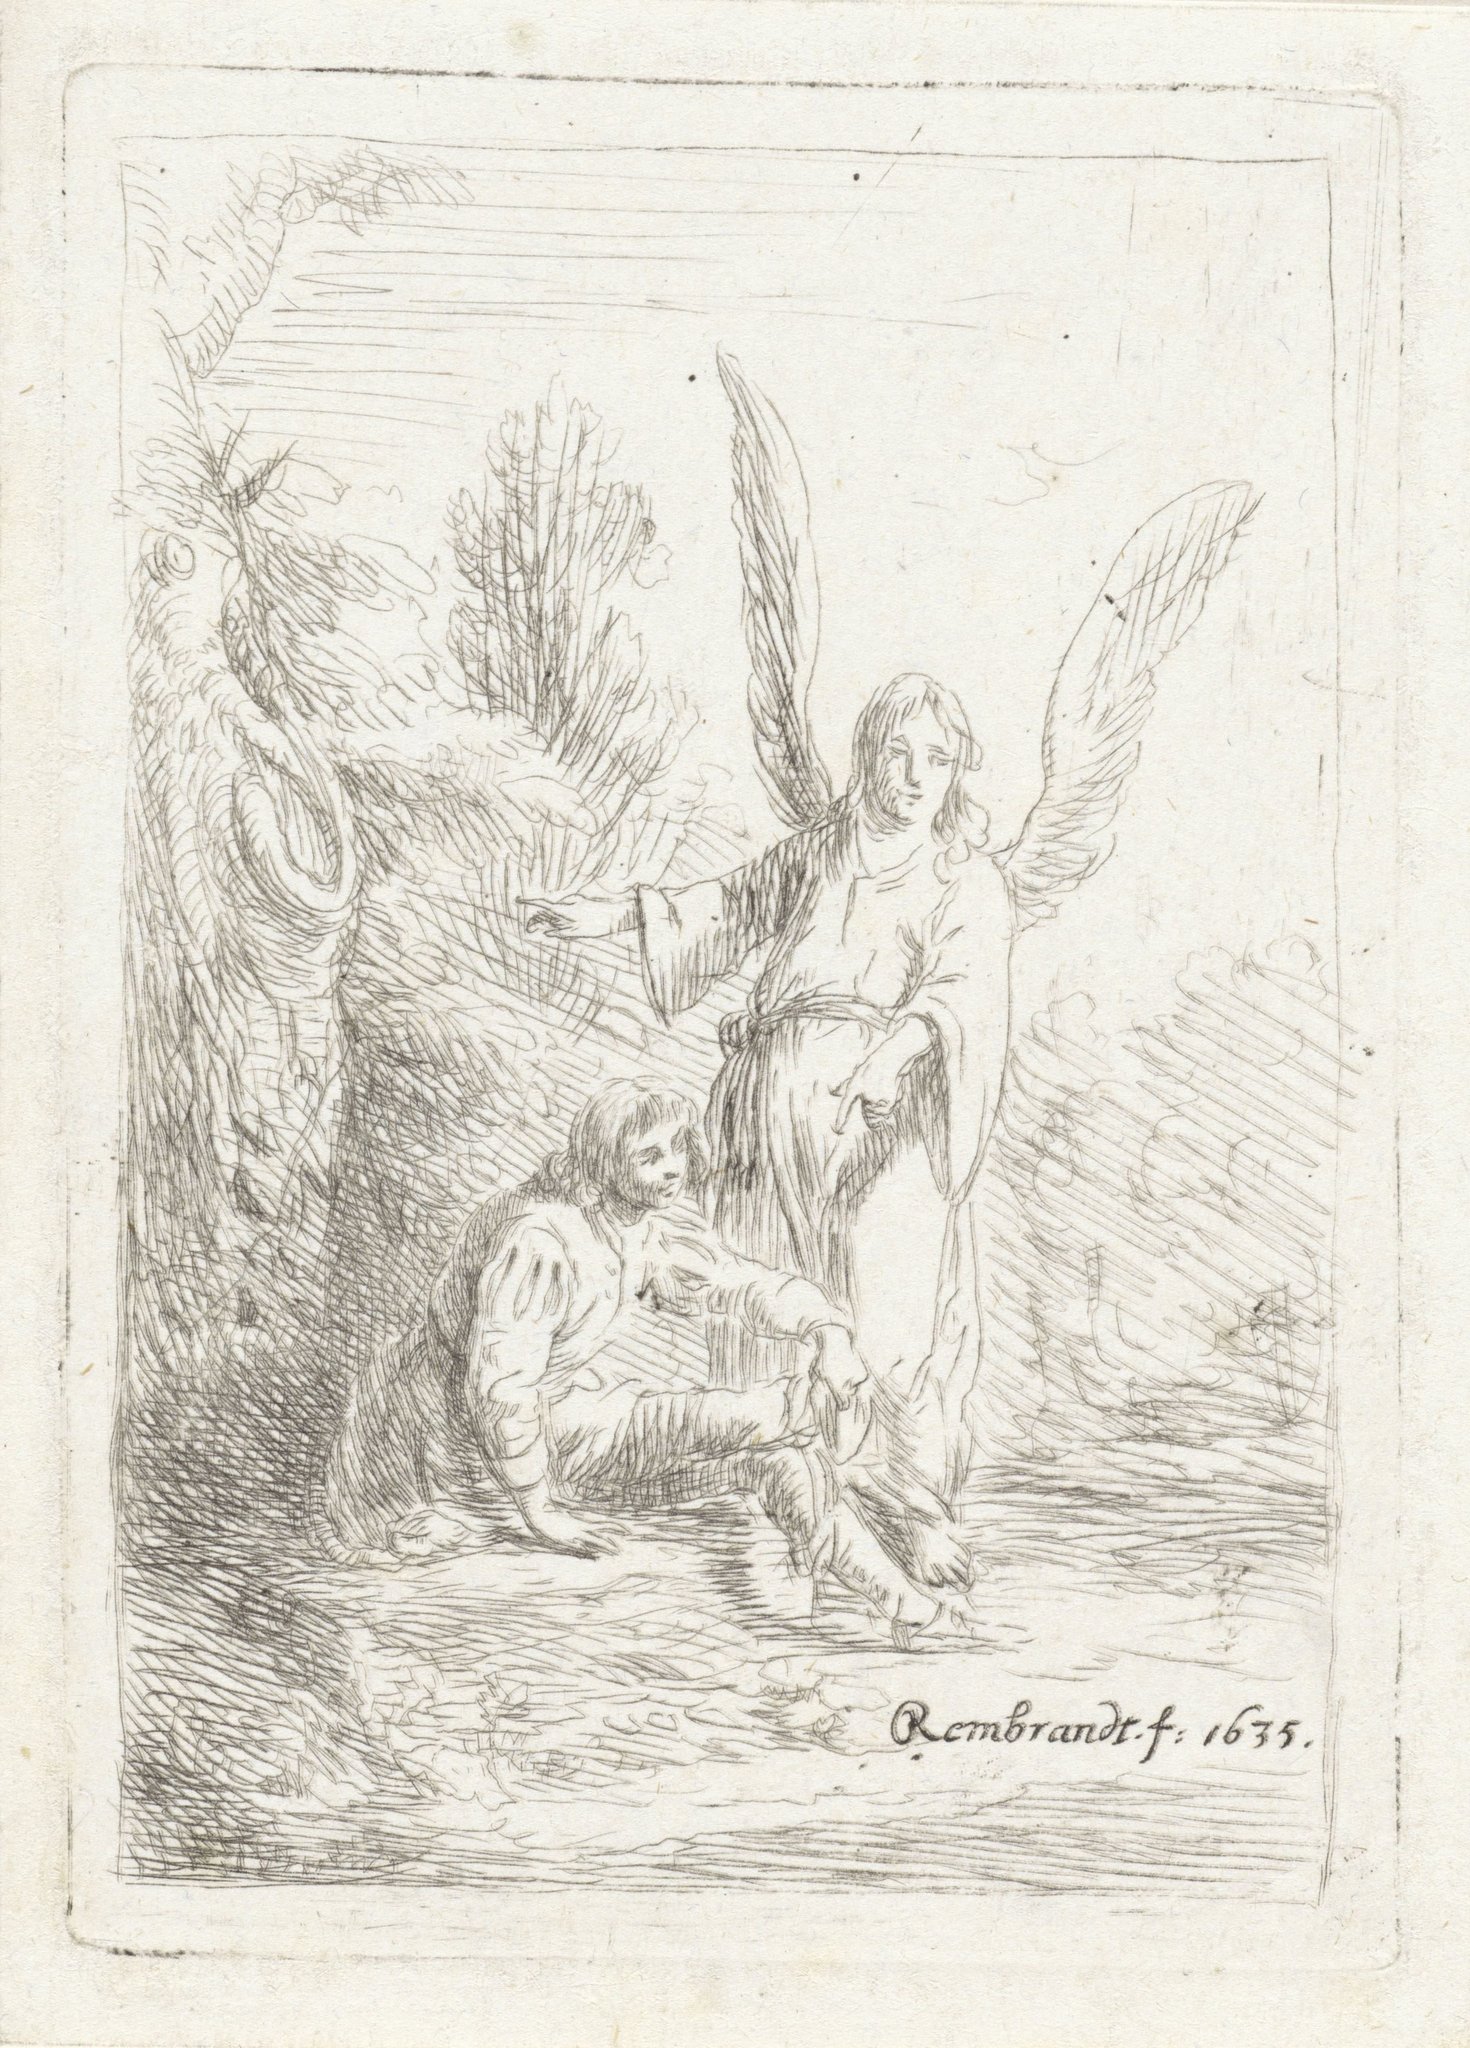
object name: print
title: Engel naast een jonge man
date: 1635-1719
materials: paper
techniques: etching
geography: northern netherlands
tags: sitting figure, landscapes, angels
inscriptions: collector's mark: Lugt 240, collector's mark: Lugt 2228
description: Links zit een jonge man, mogelijk Tobias, op de grond in een landschap. Naast hem staat een engel, mogelijkRafaël.